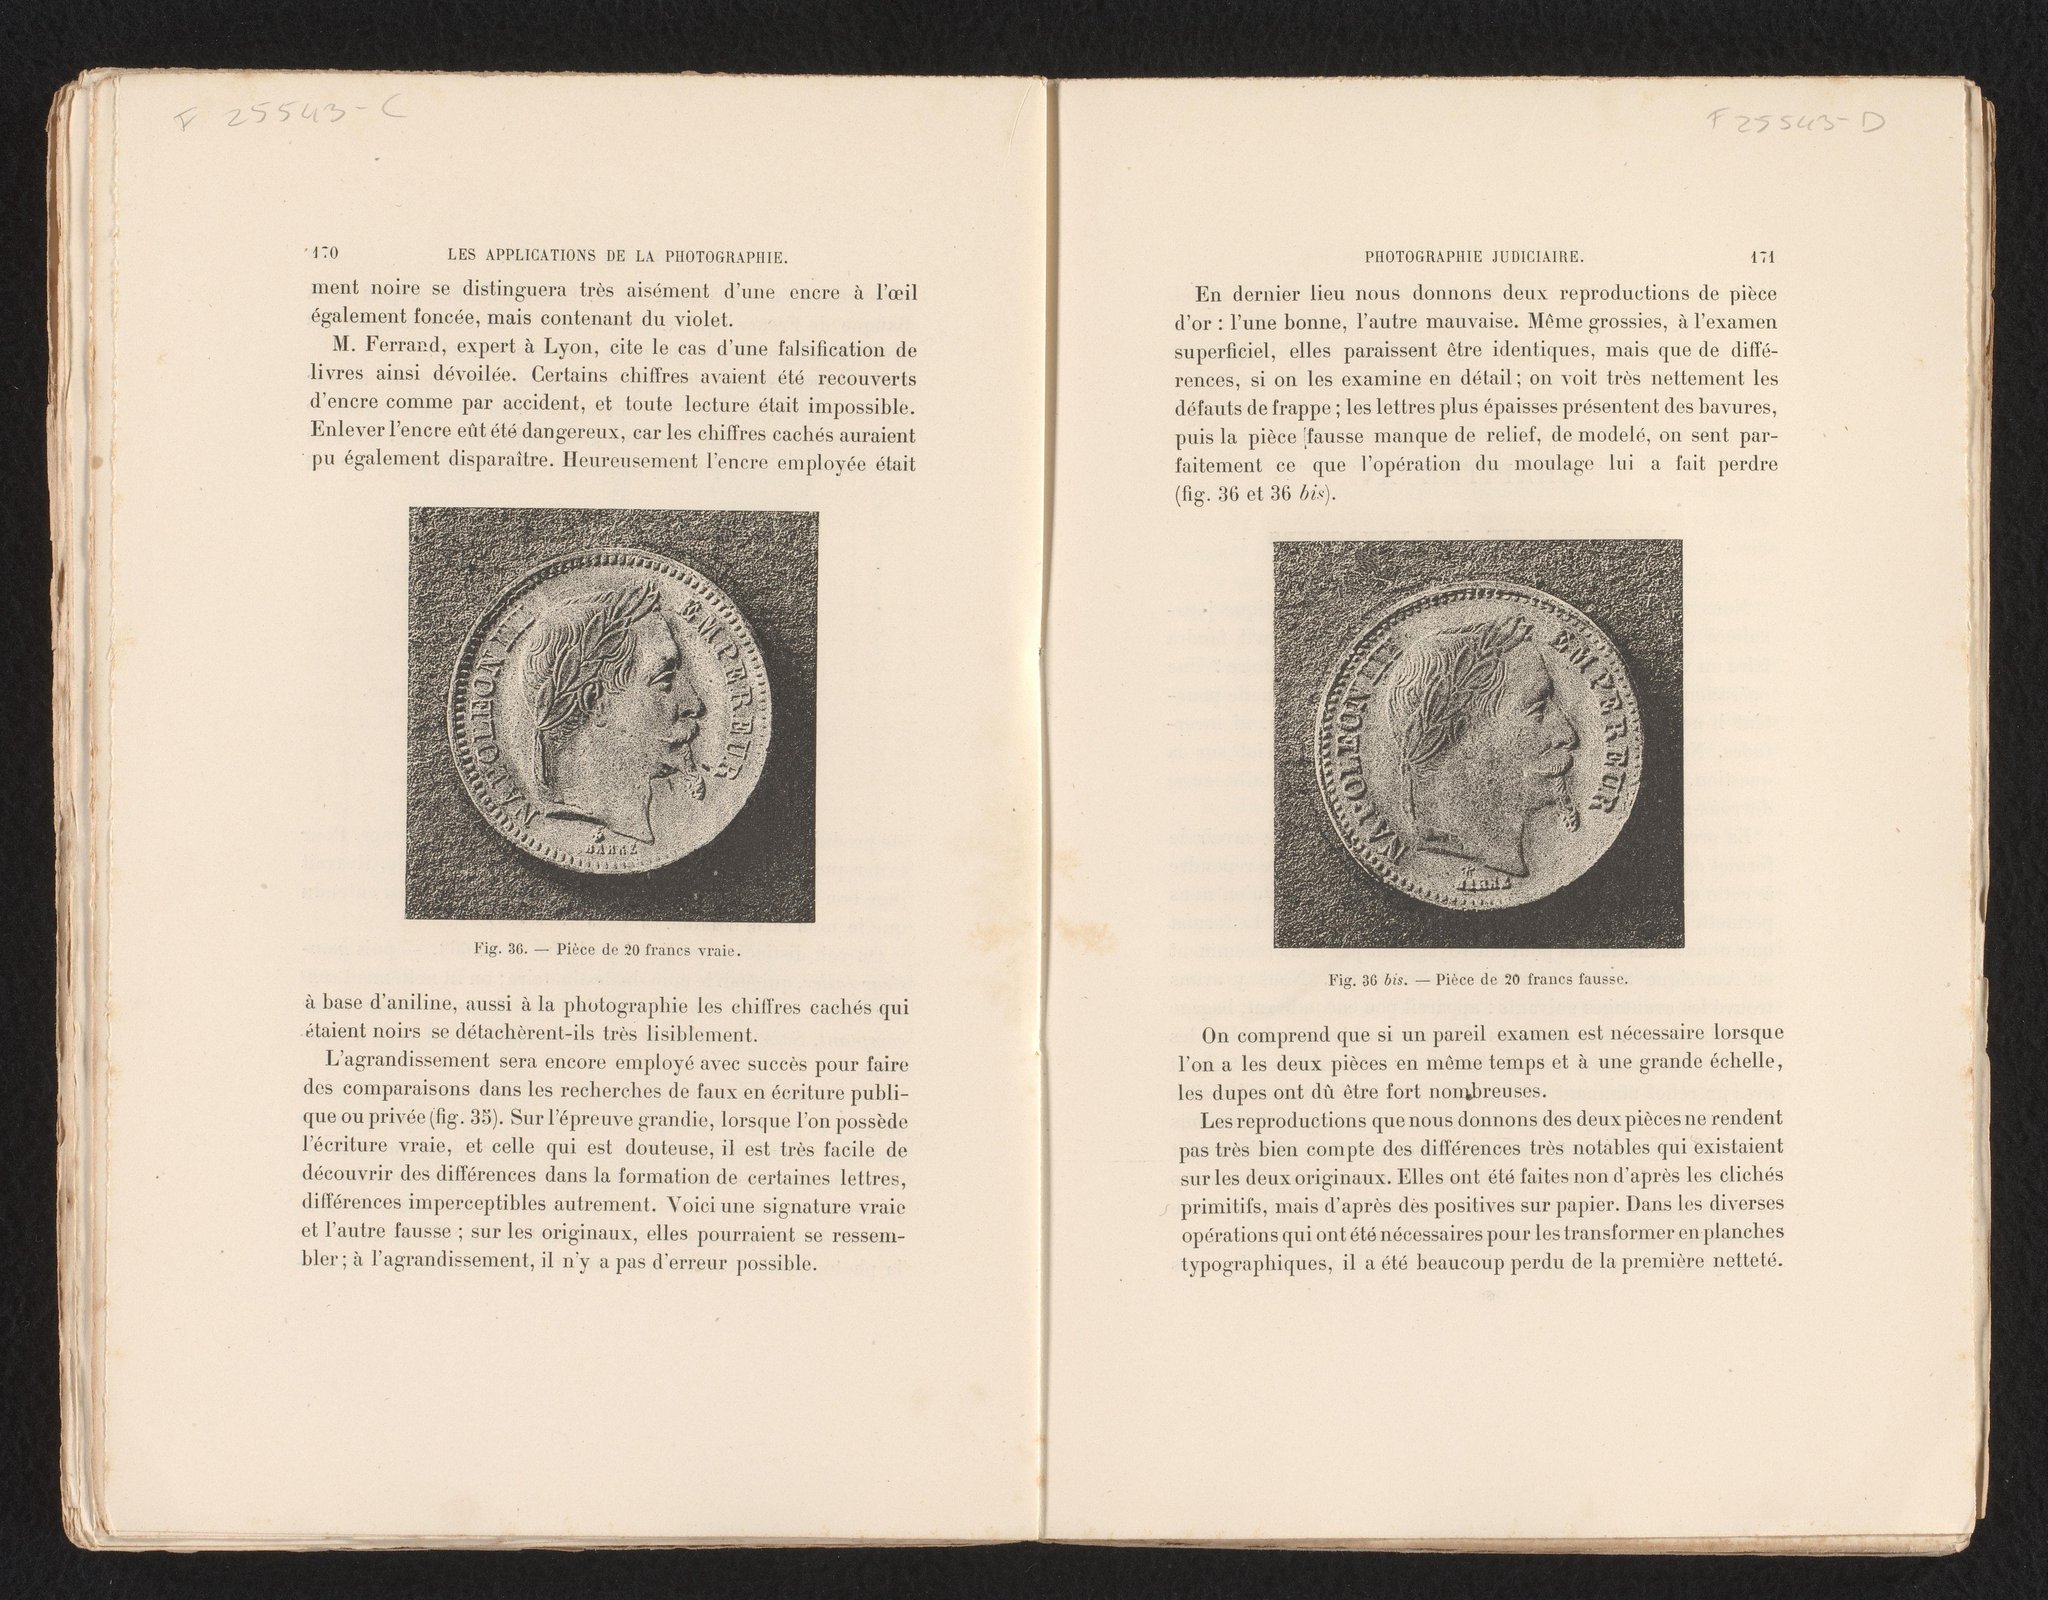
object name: photomechanical print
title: Pièce de 20 francs vraie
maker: Anonymous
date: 1883-1888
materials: paper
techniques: collo-autotype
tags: coin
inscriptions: number: ‘Fig. 36.’